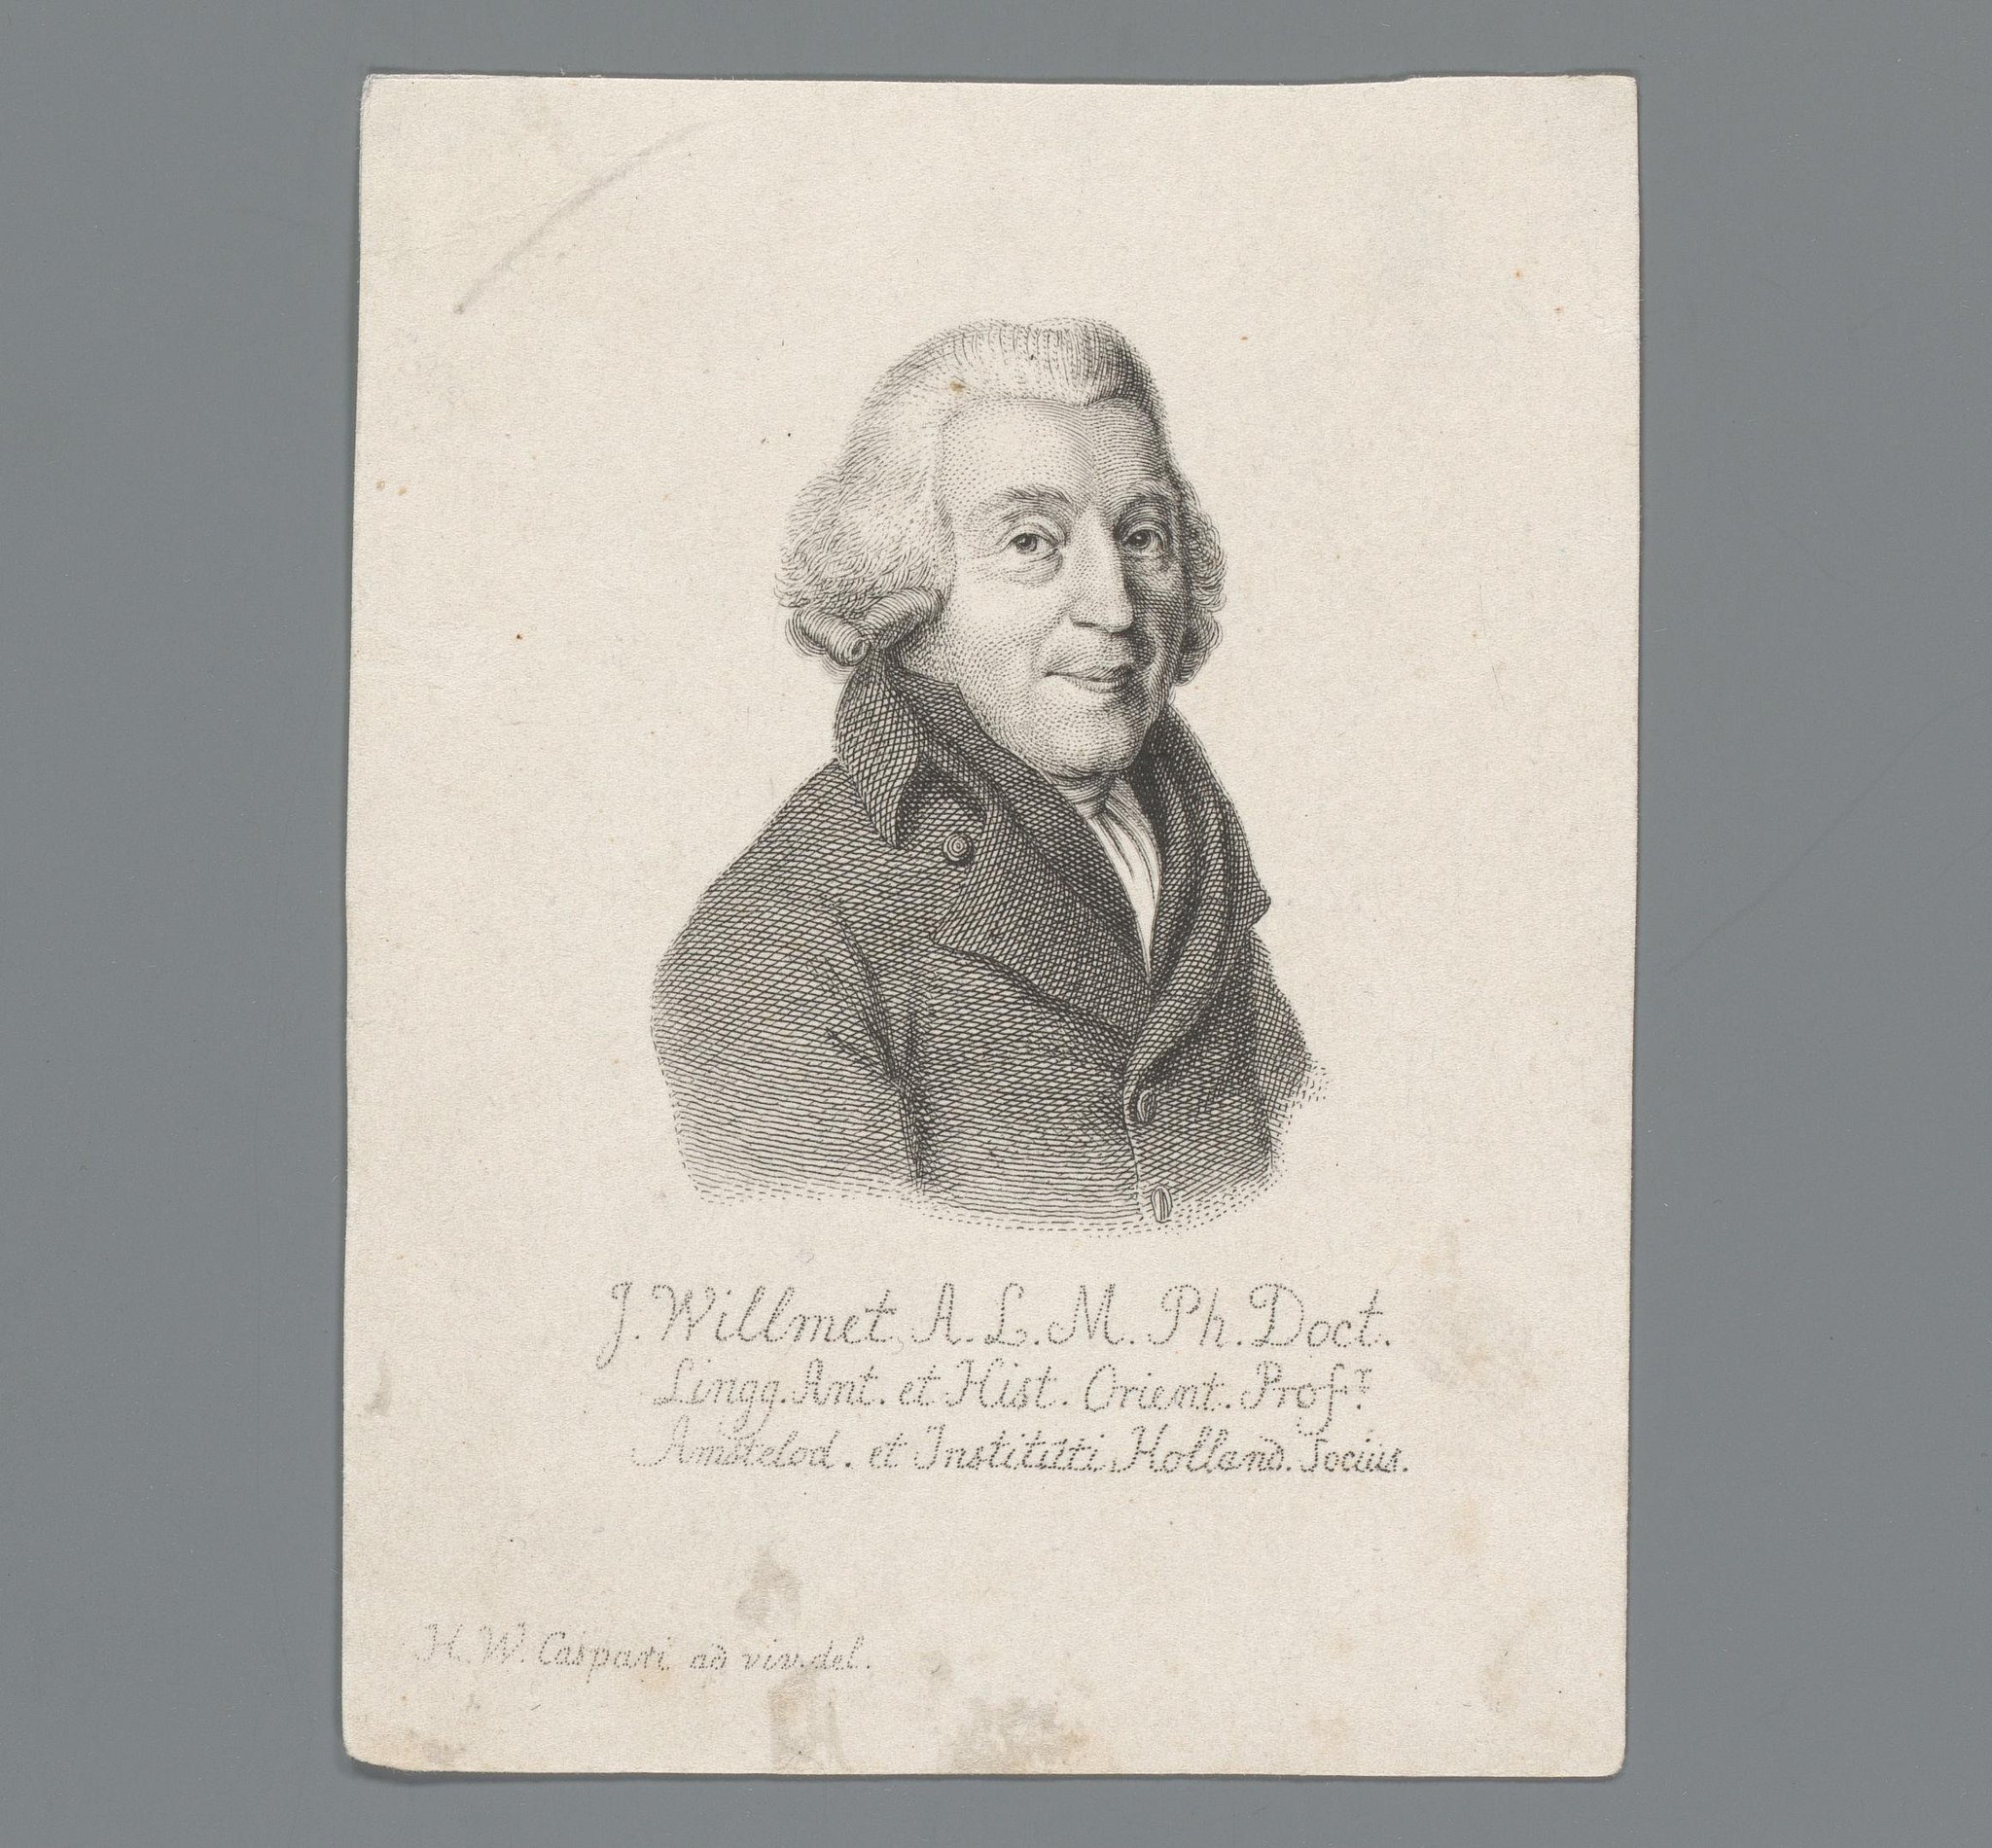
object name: print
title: Studie-prentwerk / Etudes gravées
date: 1804-1815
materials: paper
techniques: engraving, etching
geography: amsterdam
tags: amsterdam, lecture ~ university, historical persons, functionaries and dignitaries ~ protestant churches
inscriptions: stamp: ‘C.L.J.C.’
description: De prenten verschenen eerst maandelijks tussen november 1807 en juli 1816. Later gebundeld uitgegeven als: Studie-prentwerk/ Etudes gravées, ca. 1817. In 1834 volgde nog een heruitgave.